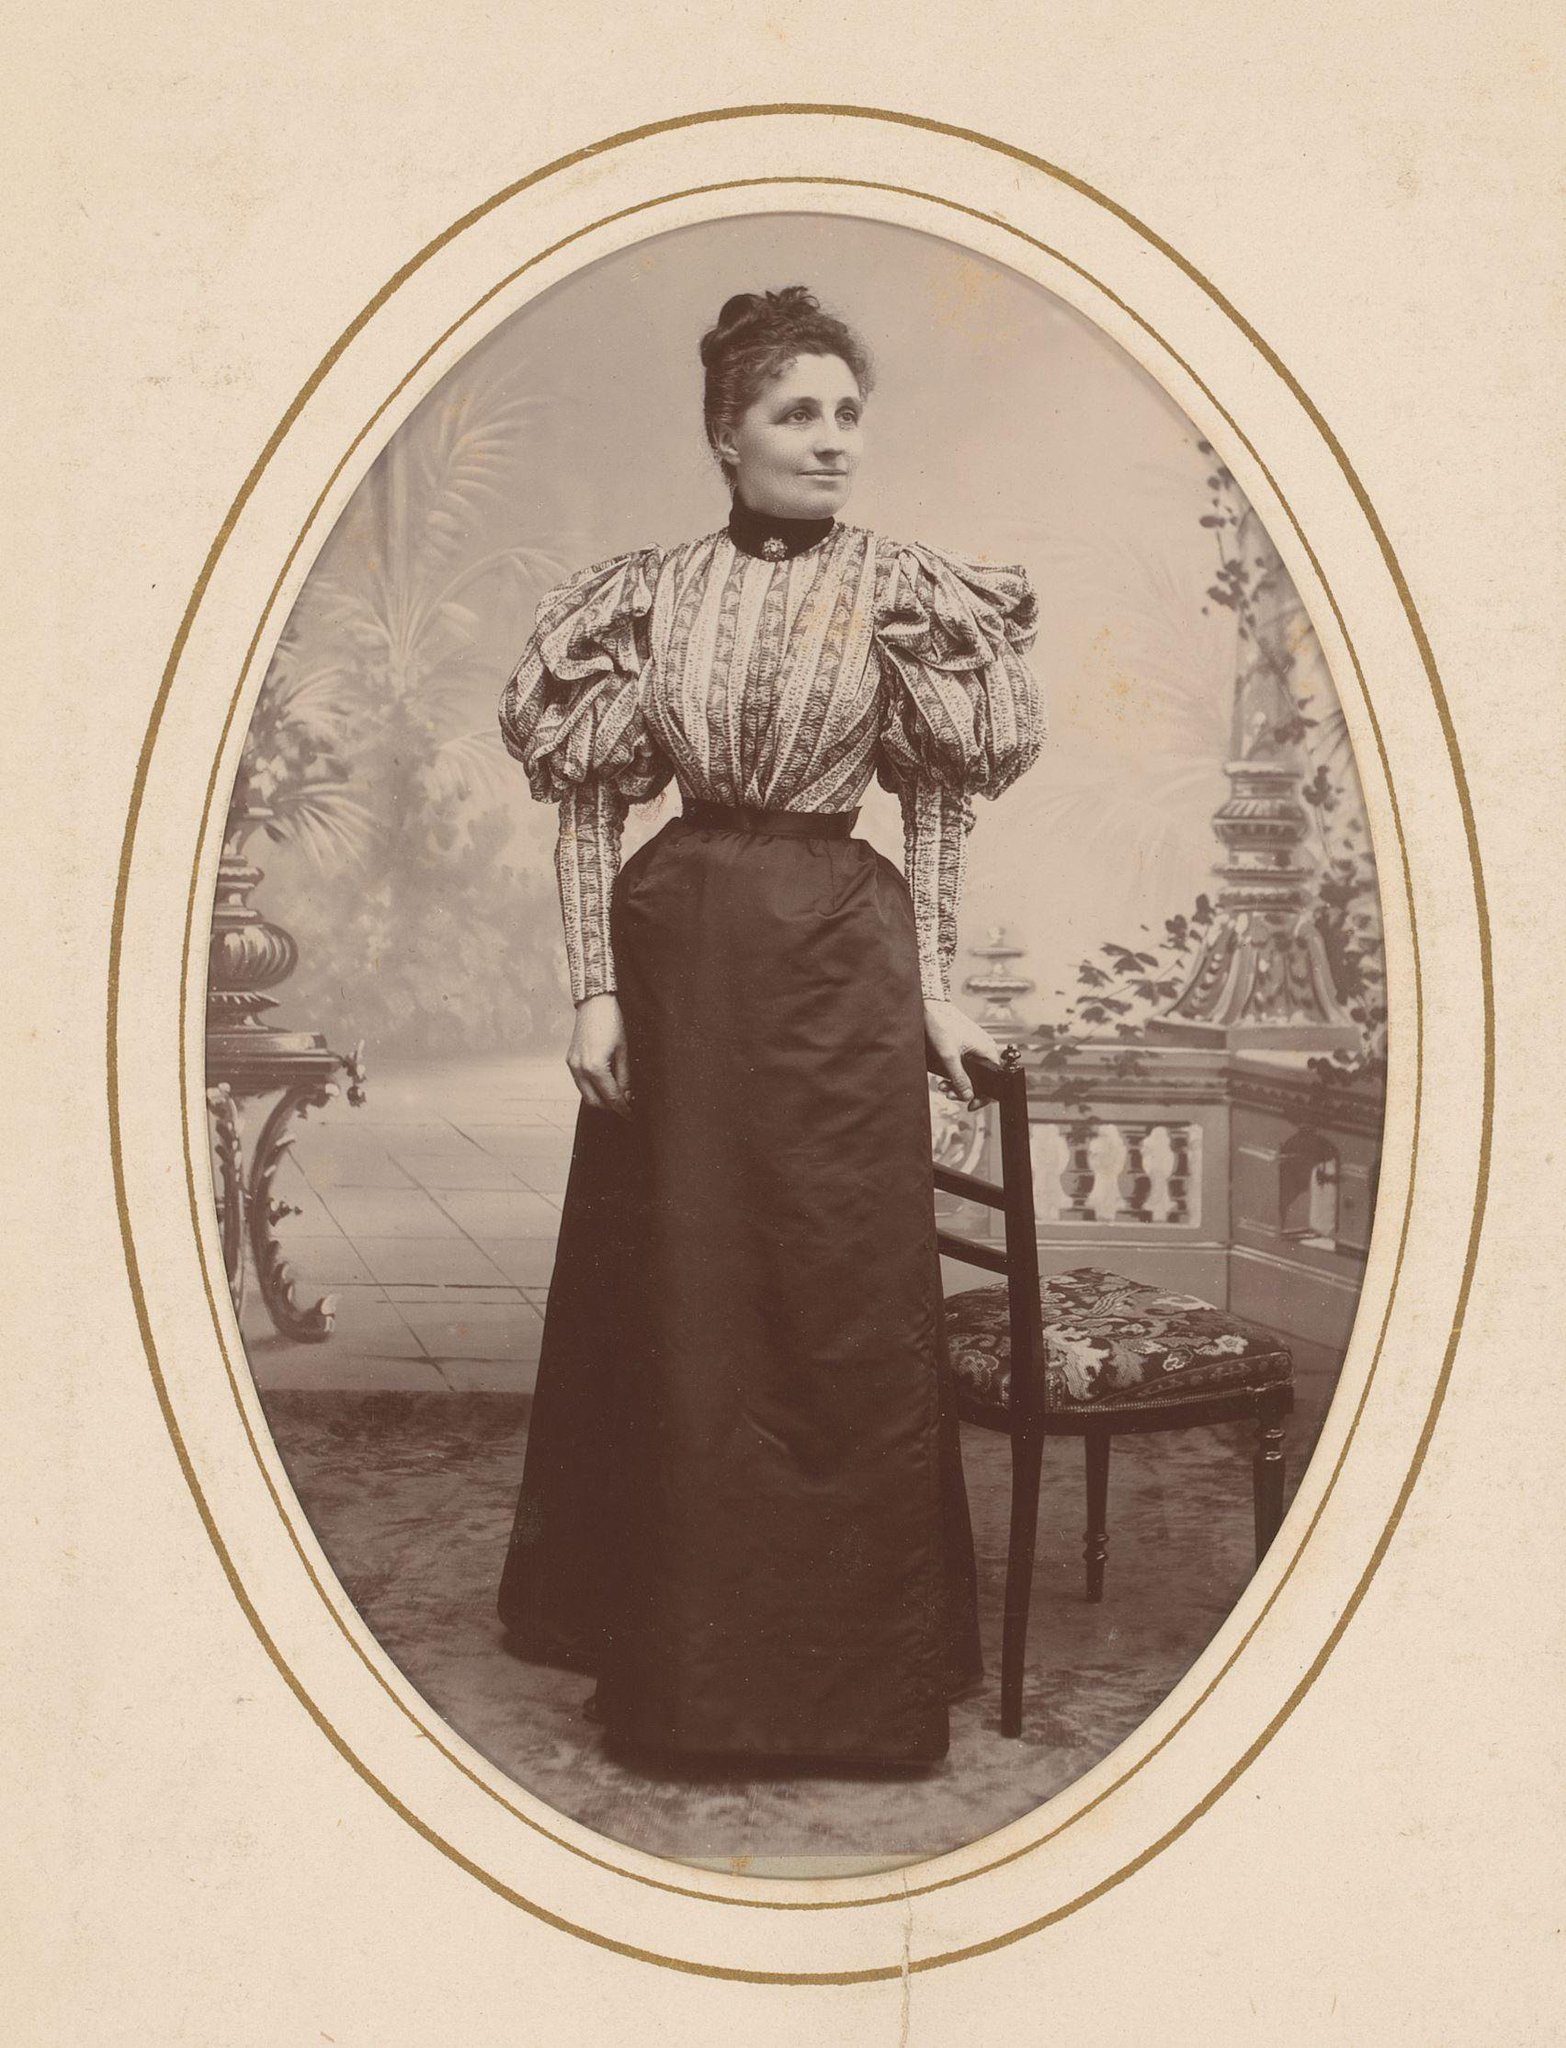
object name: album leaf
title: Portret van een vrouw, staand bij een stoel in een decor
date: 1880-1920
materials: cardboard, photographic support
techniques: collodion silver print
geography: brussels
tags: set, scenery ~ stage, historical persons - bb - woman, standing figure - aa - female human figure, chair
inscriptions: inscription: ‘Photographie d'Amateur/ grand hôtel de saxe/ F. GRADER (propriétaire)/ Bruxelles’